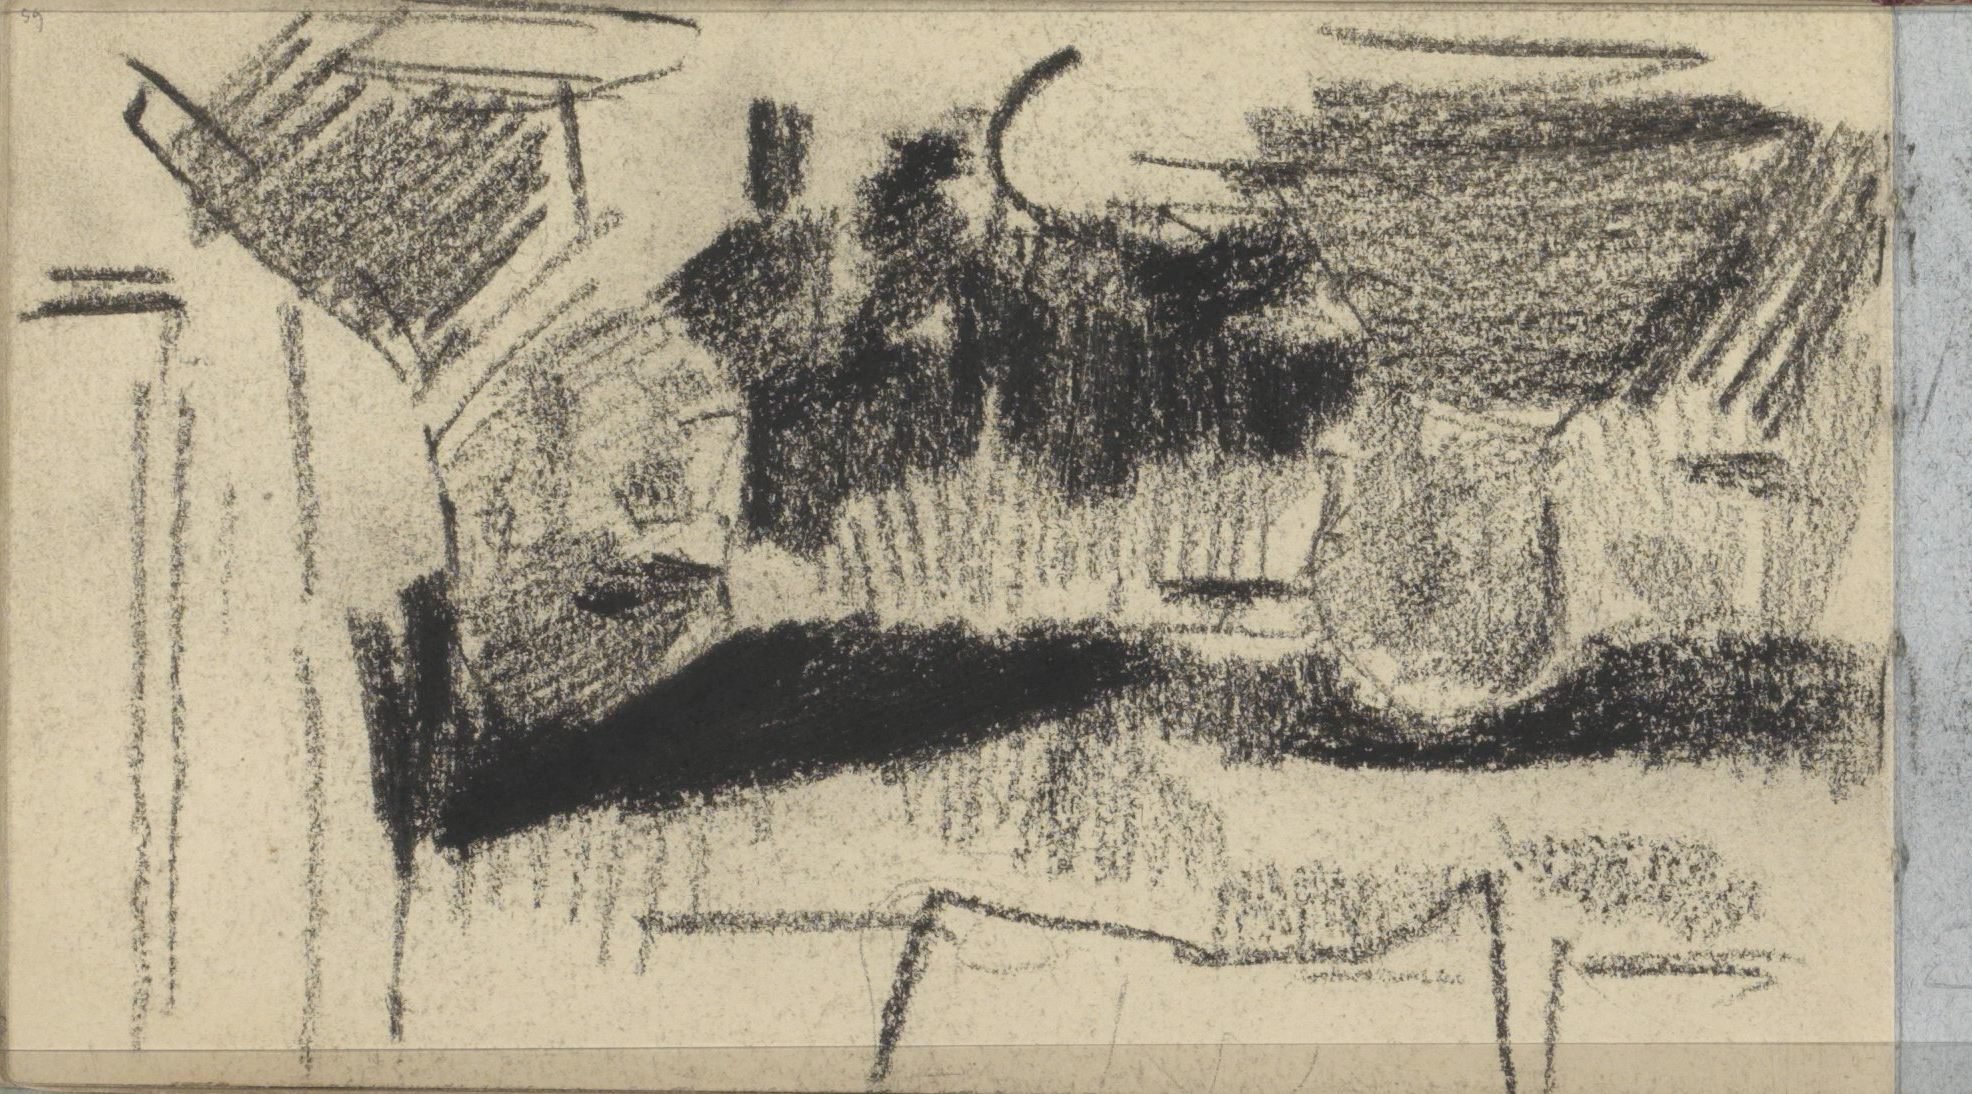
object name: sketchbook leaf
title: Twee mannen, mogelijk in een etablissement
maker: george hendrik breitner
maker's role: draughtsman, painter, print maker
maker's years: 1857-1923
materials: chalk, paper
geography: amsterdam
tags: adult man (+ two persons), inn, coffee-house, public house, etc.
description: Pagina 59 uit een schetsboek met 32 bladen.